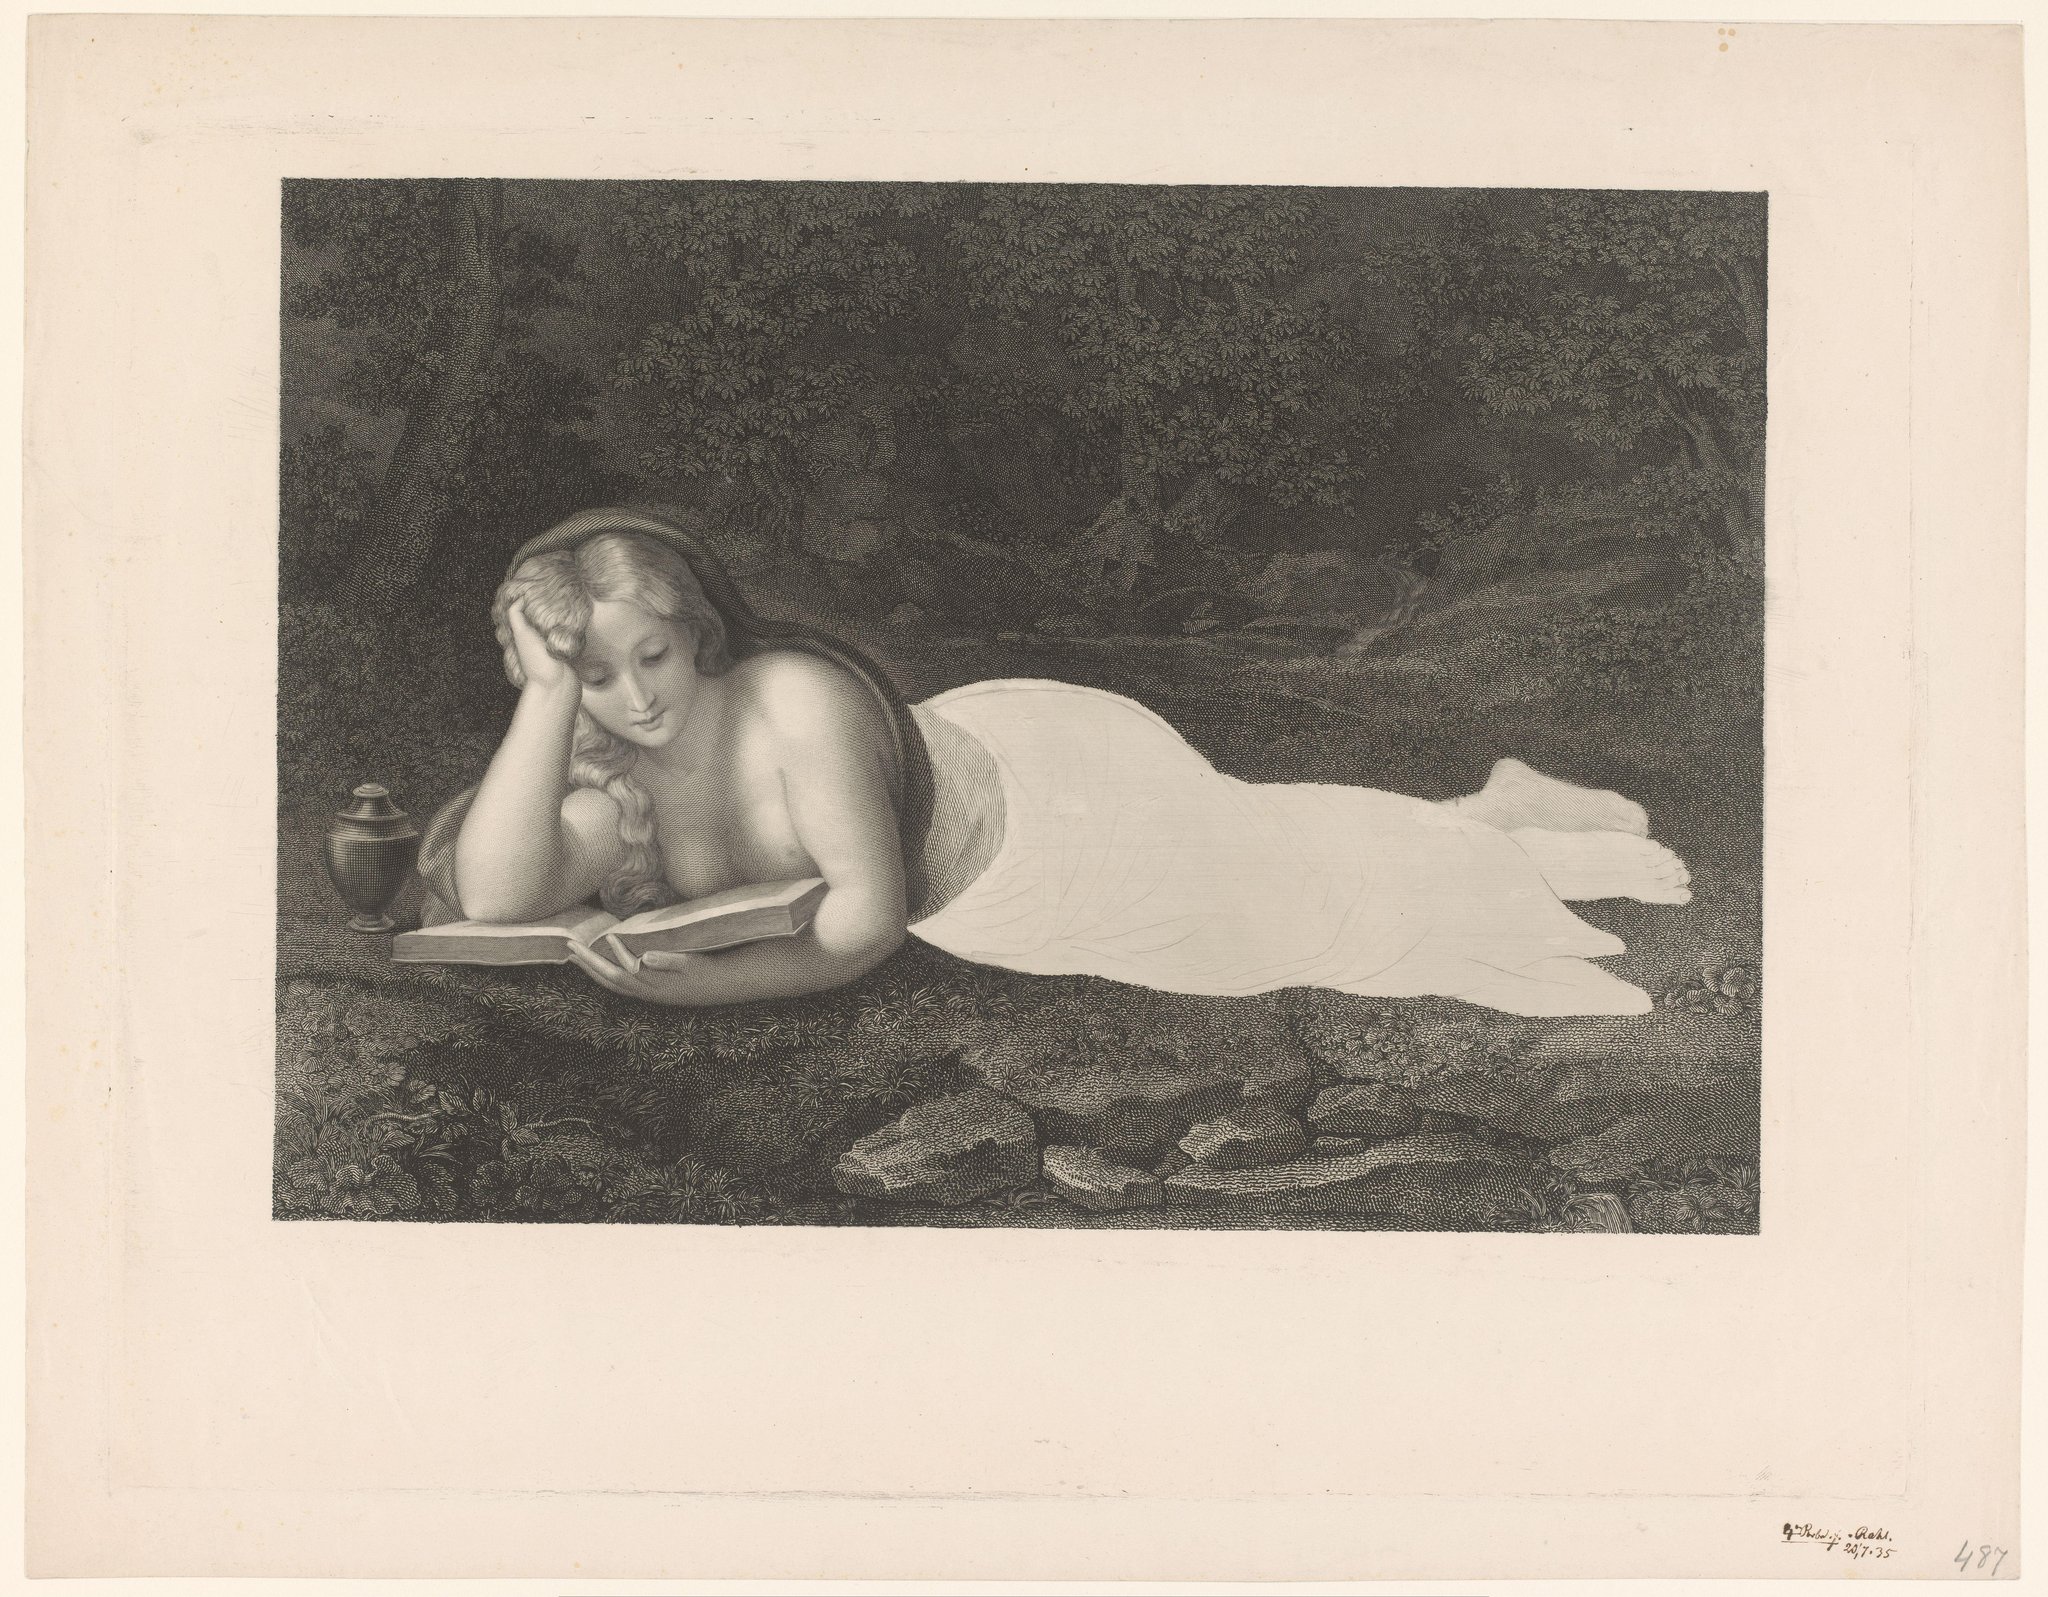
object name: print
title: Lezende Maria Magdalena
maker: carl rahl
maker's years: 1812-1865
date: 1826-1827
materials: paper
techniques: engraving, etching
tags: reading, the penitent harlot mary magdalene; possible attributes: book (or scroll), crown, crown of thorns, crucifix, jar of ointment, mirror, musical instrument, palm-branch, rosary, scourge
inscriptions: inscription: ‘4e Probe -f- Rahl/ 20/7-35’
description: De lezende Maria Magdalena ligt op de grond met voor haar de zalfpot.